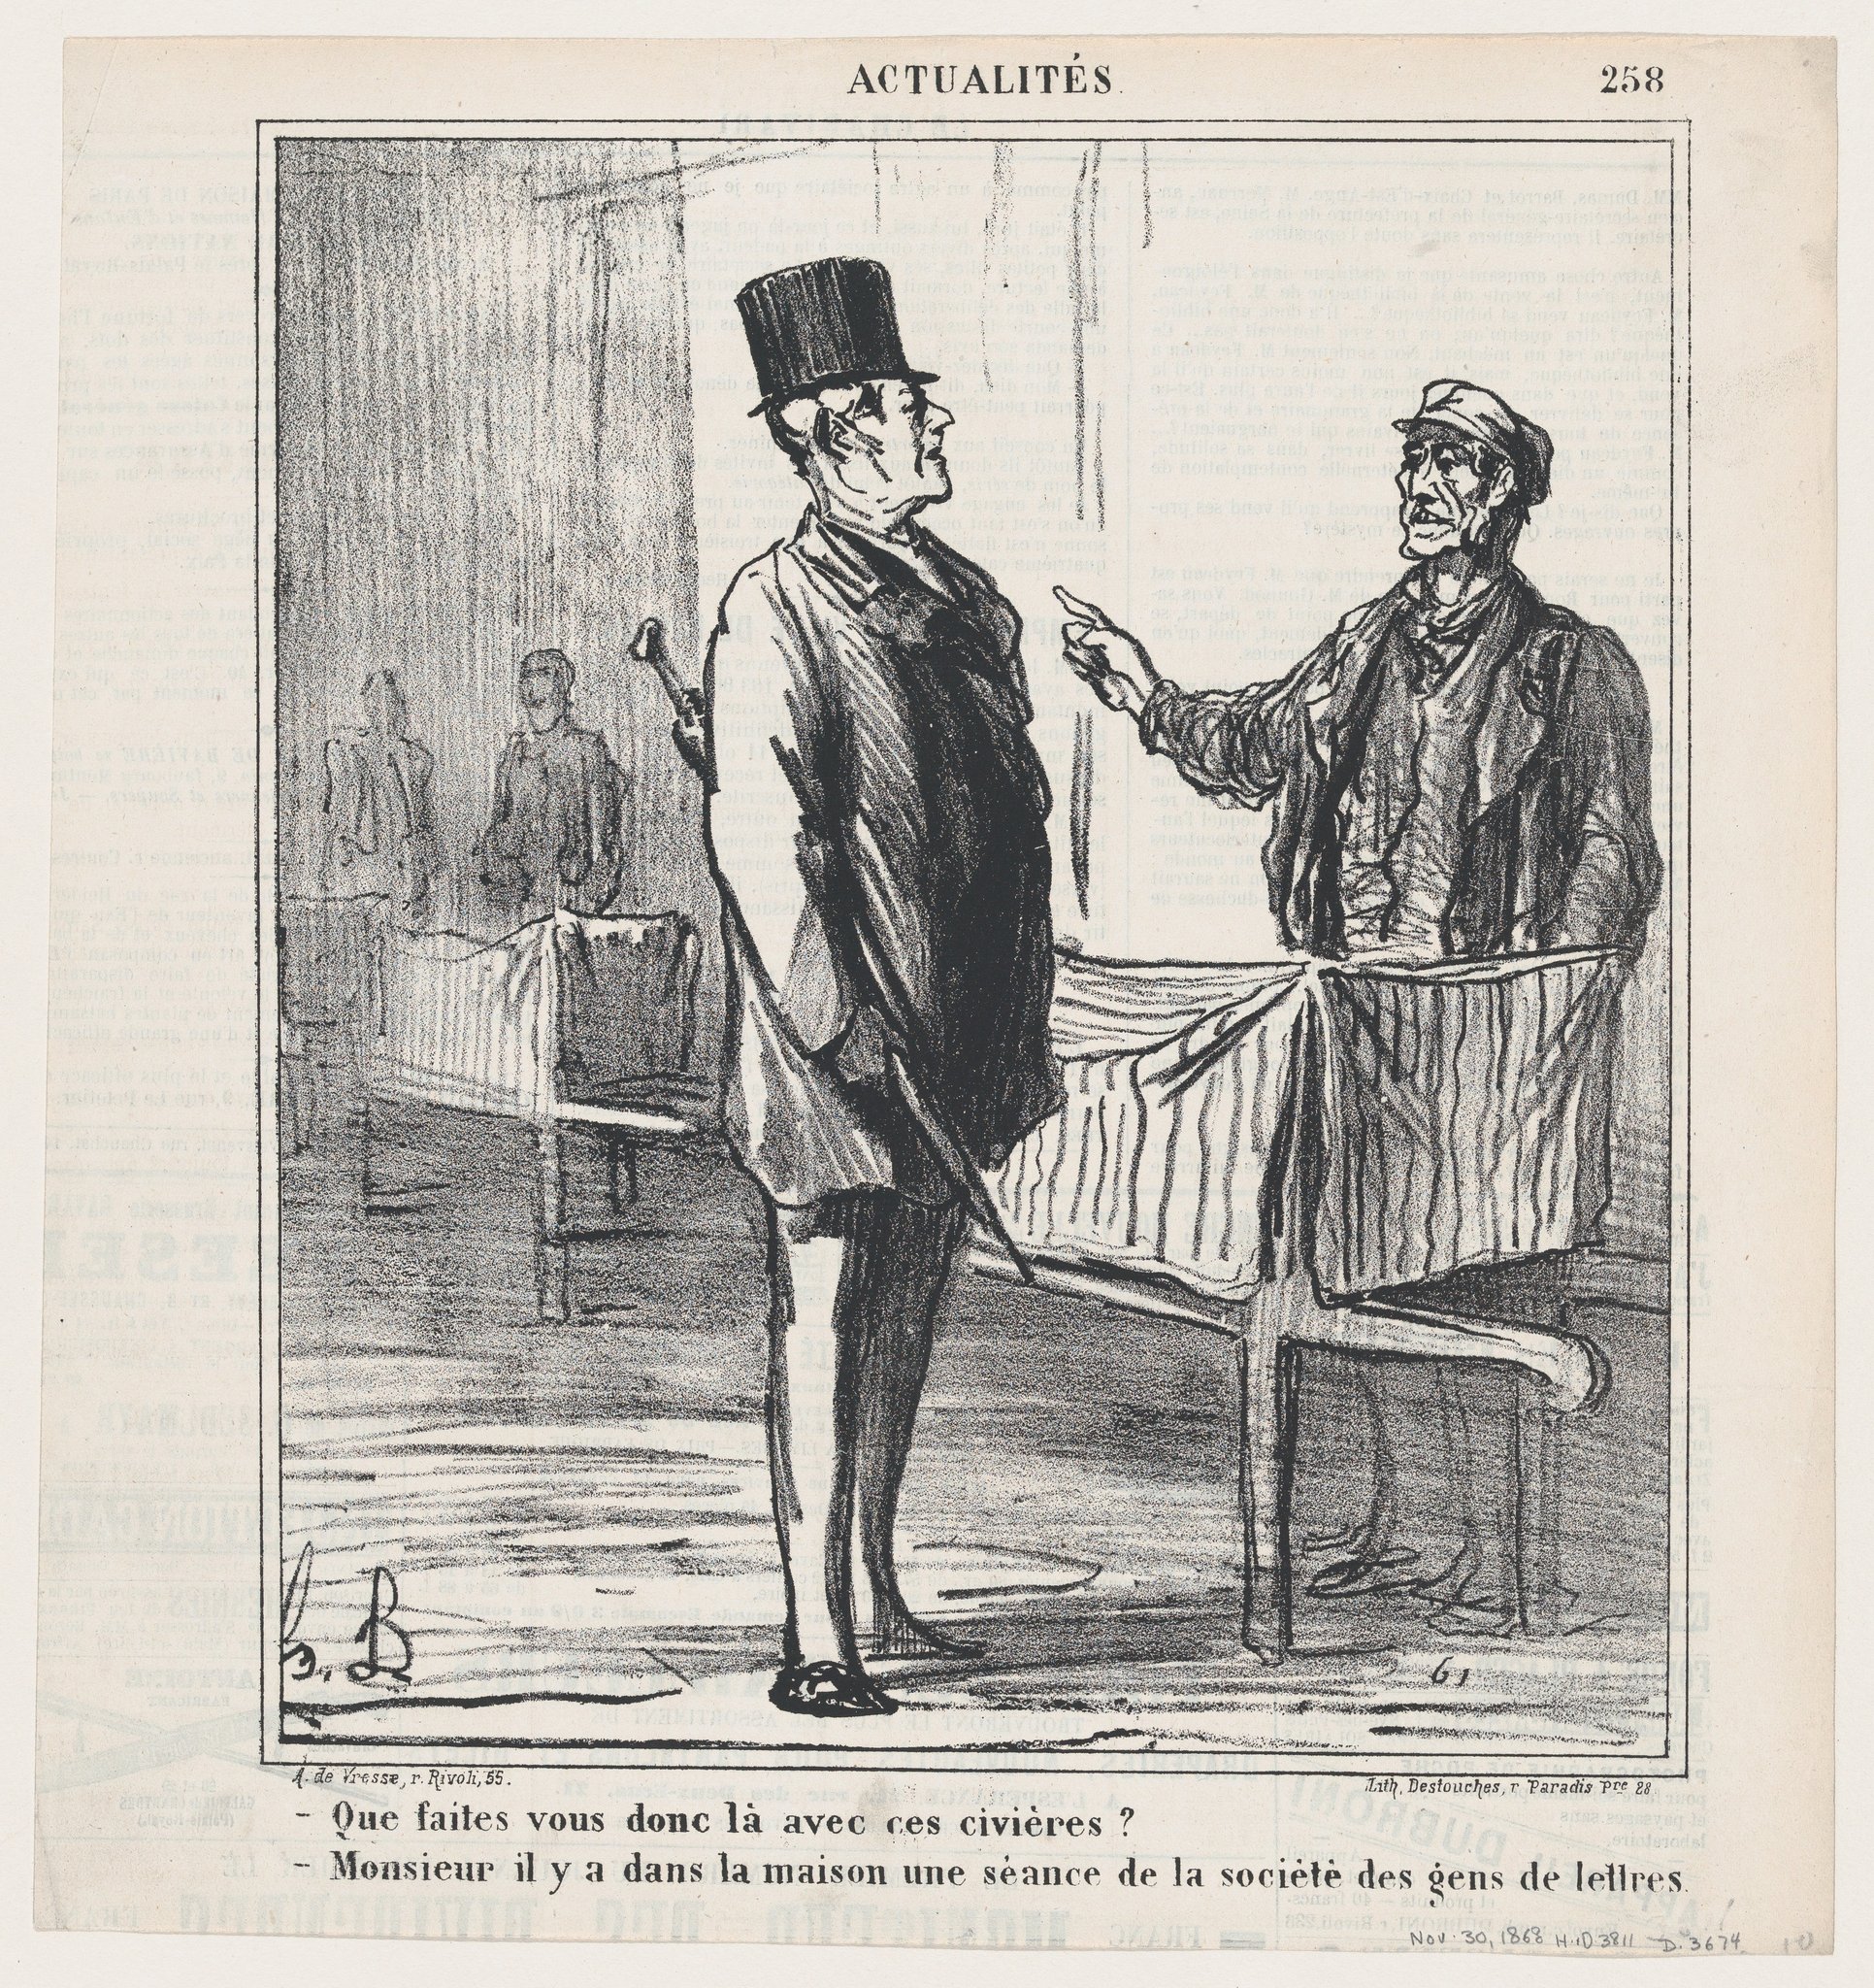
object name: print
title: – What are you doing with these stretchers? – Monsieur, a reunion of the literary society is taking place in this house, from "News of the day"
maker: honoré daumier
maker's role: artist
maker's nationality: french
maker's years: 1808-1879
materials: paper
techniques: lithograph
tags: men